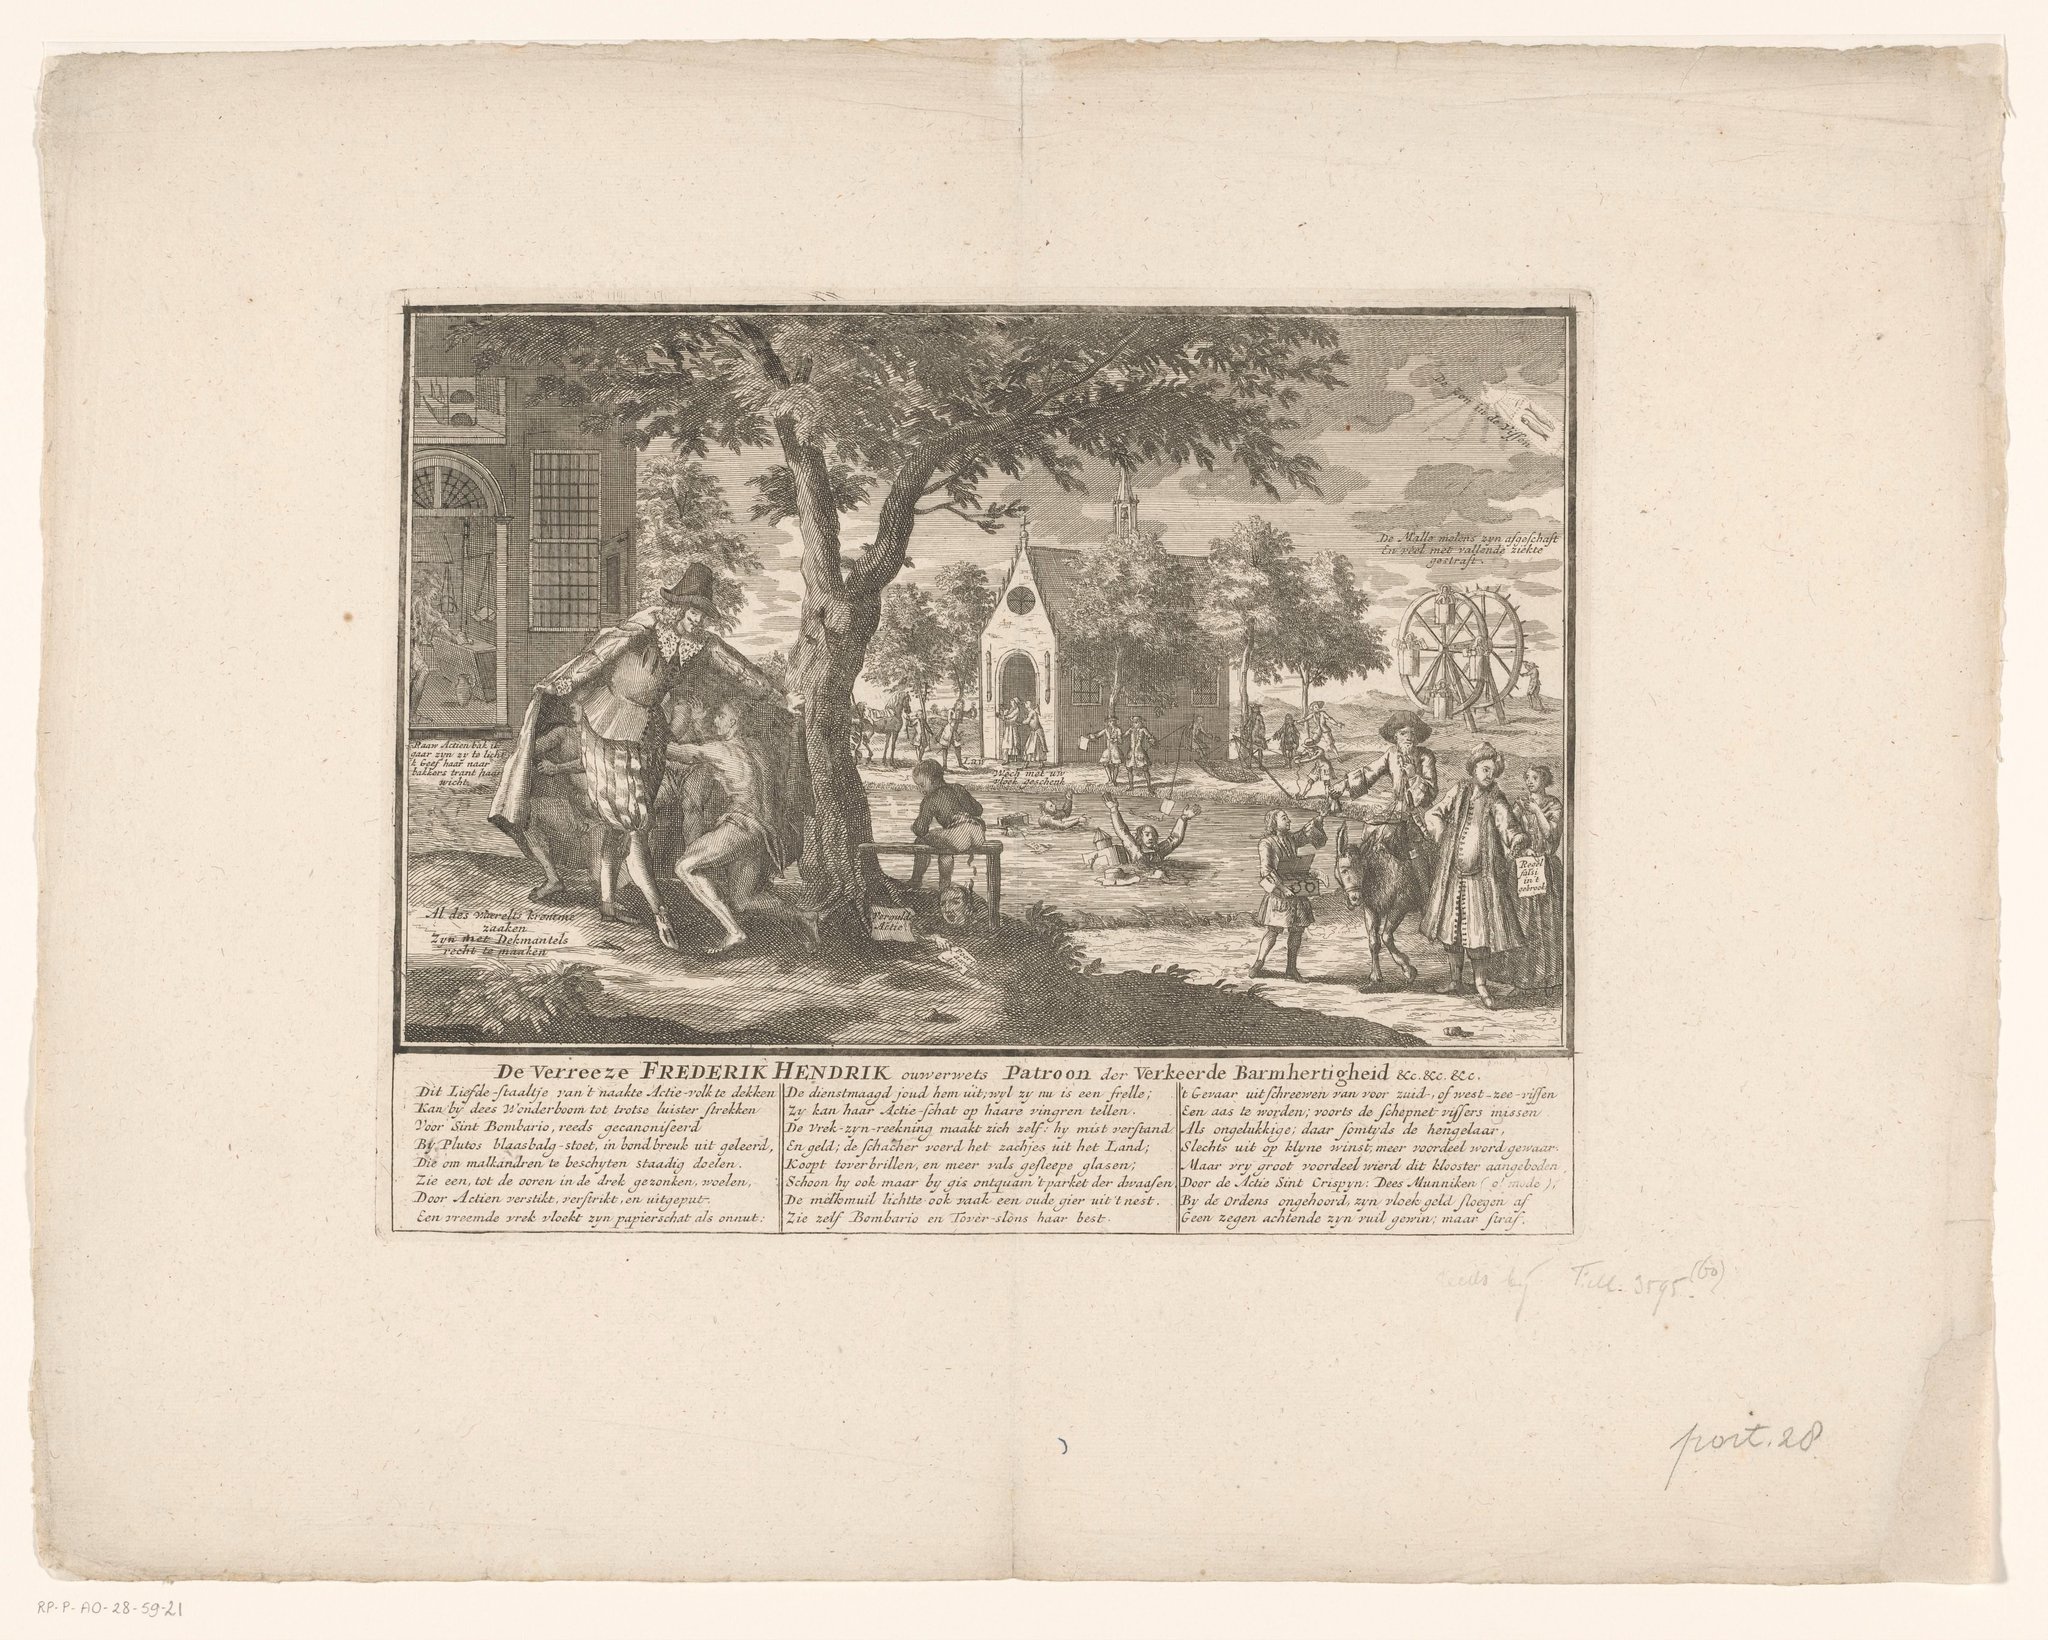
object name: cartoon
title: De verreeze Frederik Hendrik ouwerwets patroon der Verkeerde Barmhertigheid &c. &c. &c.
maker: Anonymous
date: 1720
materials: paper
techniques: engraving, etching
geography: northern netherlands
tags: the hague, frederick henry (prince of orange), merry-go-round, roundabout; chair o'plane, financial panic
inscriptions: collector's mark: Lugt 2228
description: Een herrezen Frederik Hendrik verleent bij de wonderboom barmhartigheid aan de naakte en berooide actionisten door hen onder zijn mantel een schuilplaats te bieden. Dit is een verbeelding van een oud spreekwoord: zich dekken met de mantel van Frederik Hendrik, wat betekent: vrij zijn van vervolging op financieel gebied. In het midden verdrinken windhandelaren in een sloot, rechts een draaimolen. Met onderschrift in twee kolommen. Prent 60 in de serie Het Groote Tafereel der Dwaasheid met spotprenten op de Windhandel of Actiehandel van 1720.